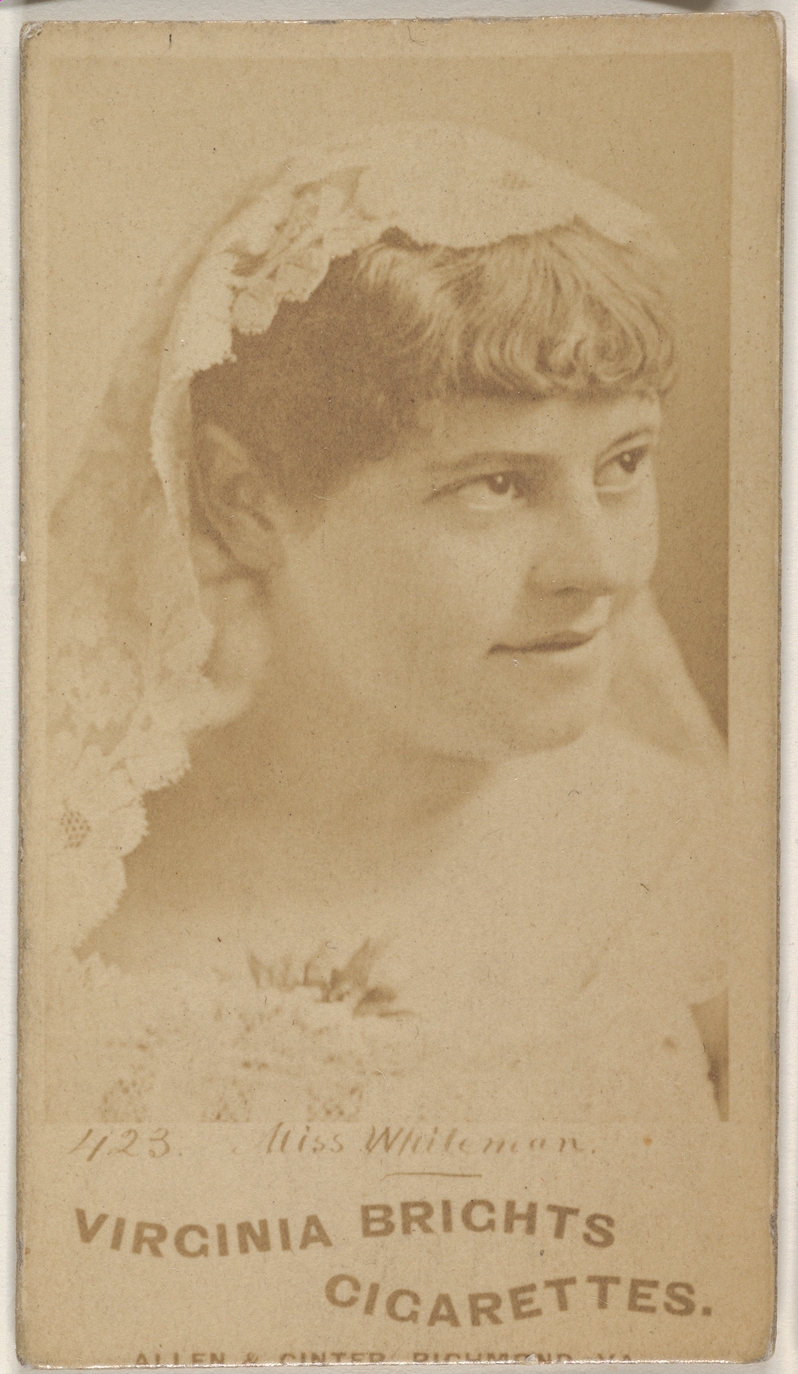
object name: photograph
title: Card 423, Miss Whiteman, from the Actors and Actresses series (N45, Type 1) for Virginia Brights Cigarettes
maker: allen & ginter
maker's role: publisher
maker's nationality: american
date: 1888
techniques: albumen silver print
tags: portraits,women,actresses